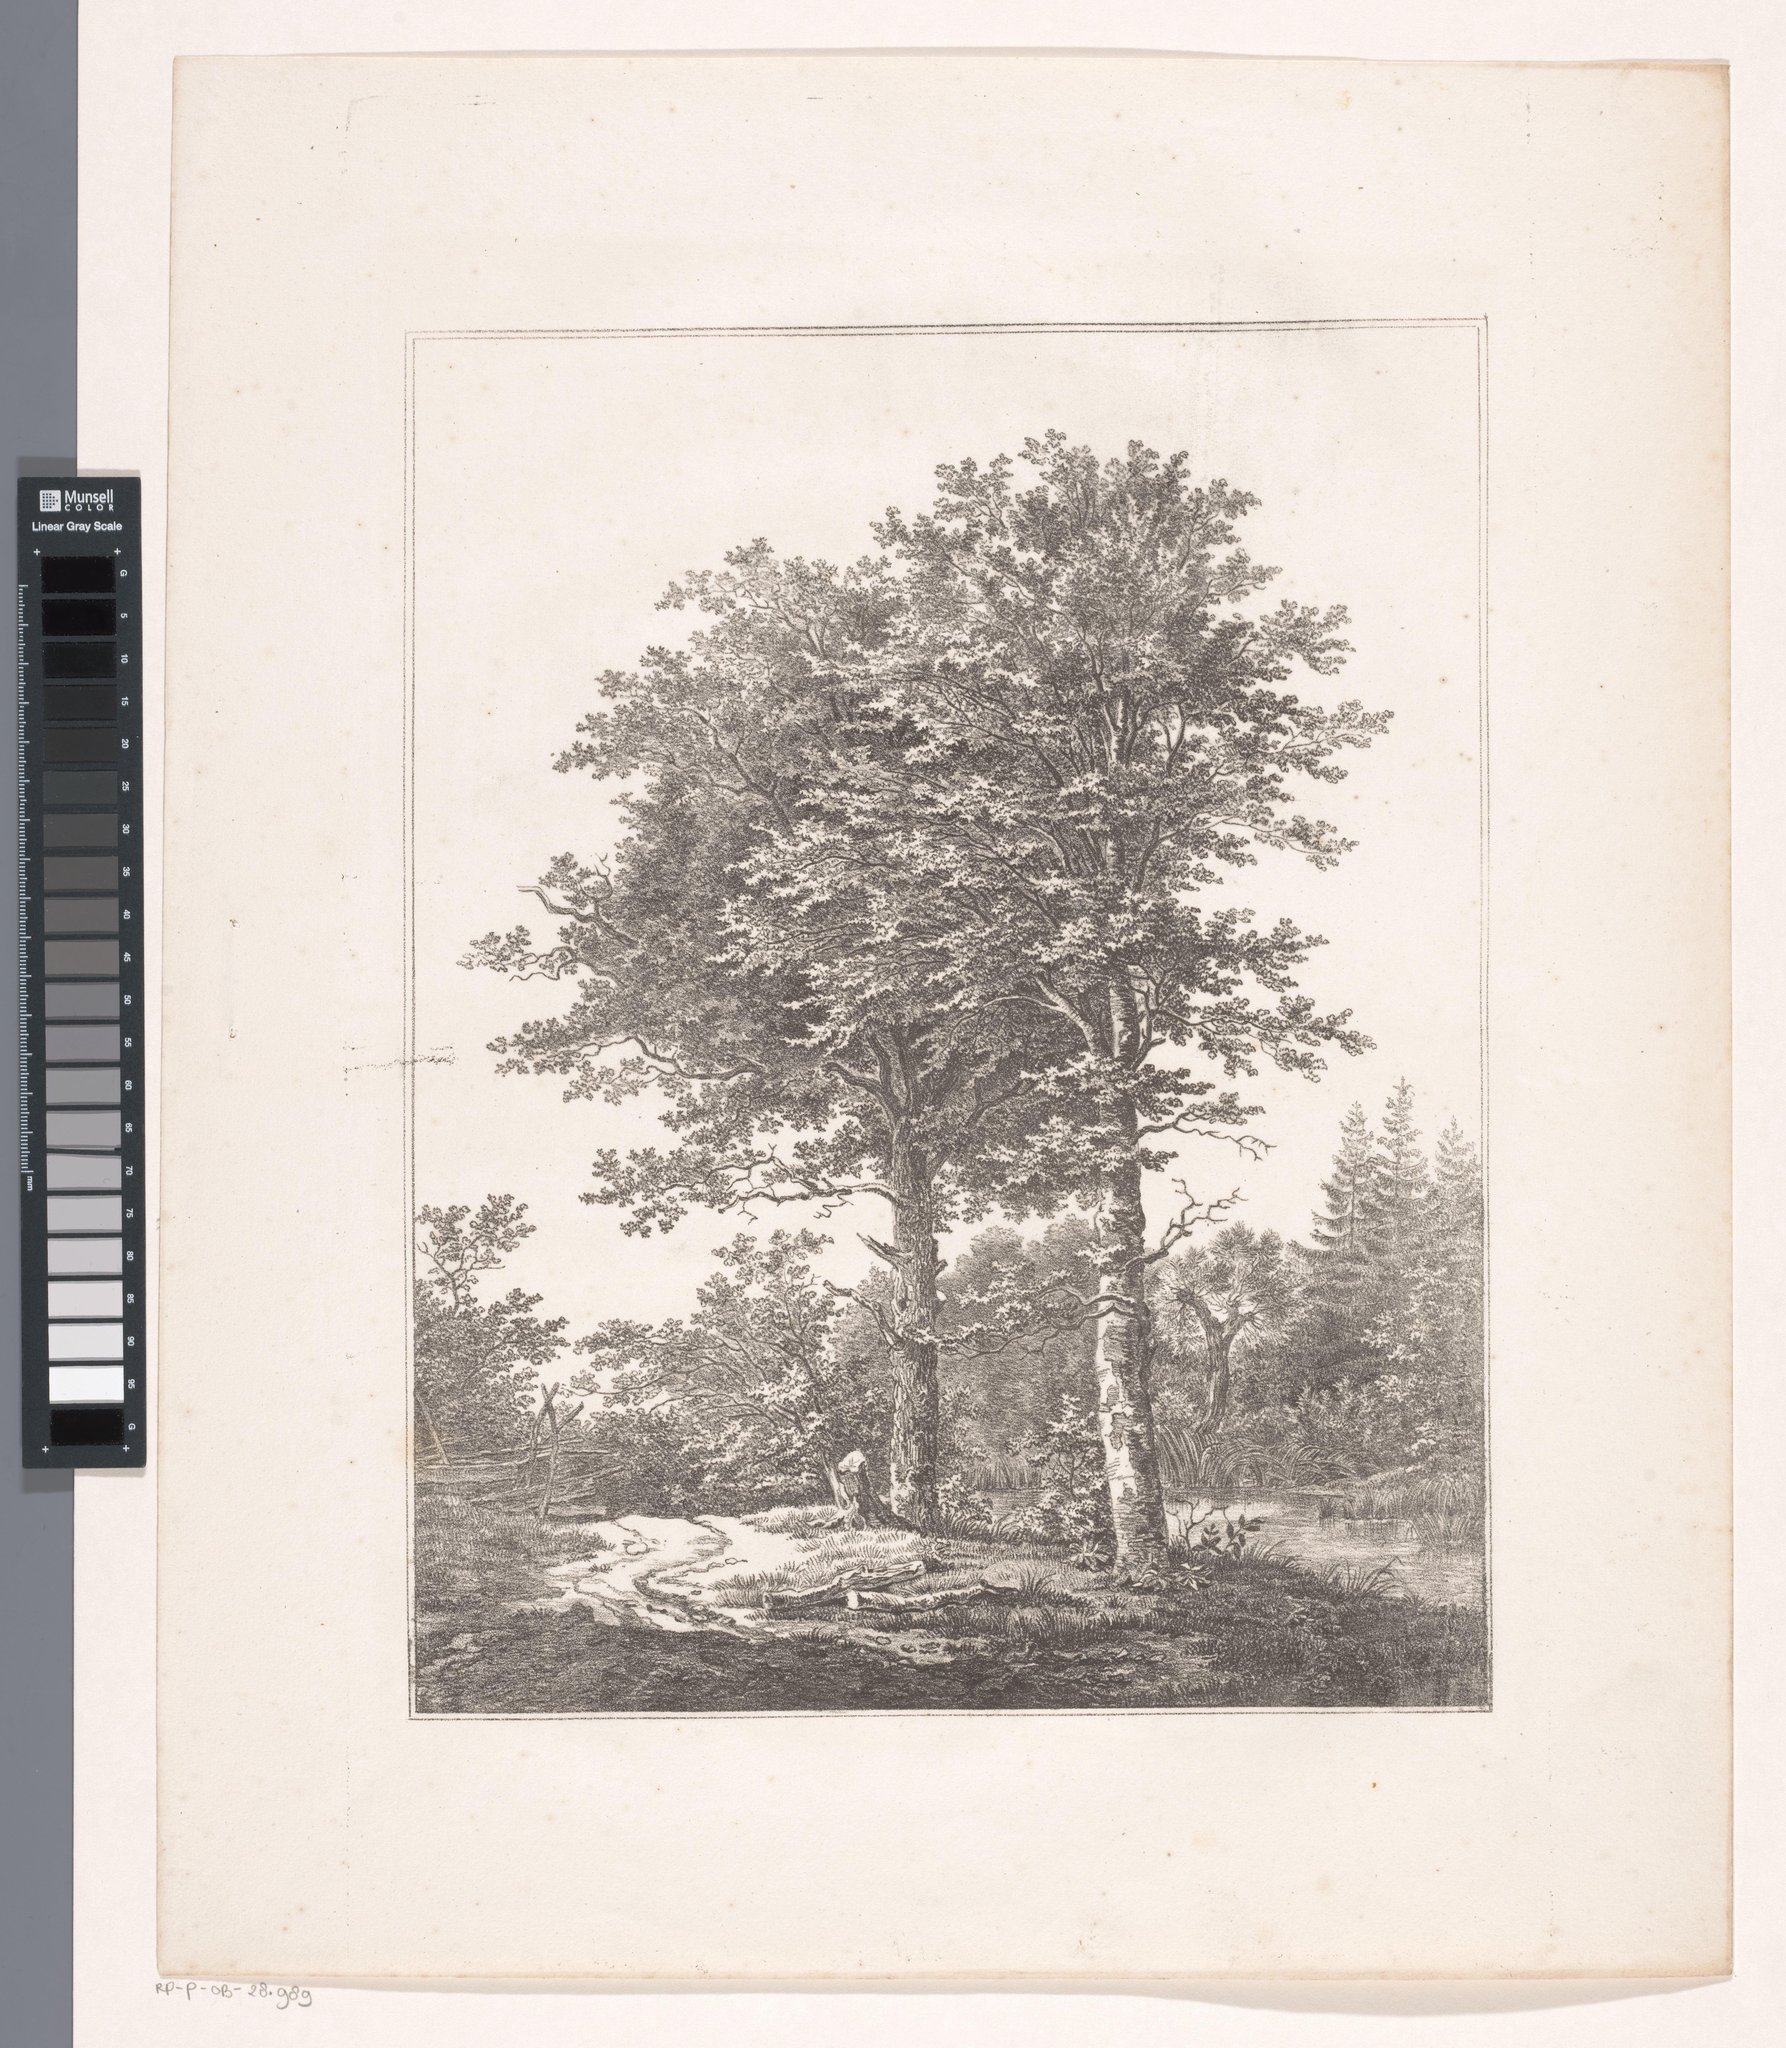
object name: print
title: Boomstudiën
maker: adrianus van der koogh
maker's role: draughtsman, print maker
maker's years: 1796-1831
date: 1826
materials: paper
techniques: lithograph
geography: dordrecht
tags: forest, wood, groups of trees, small canal, ditch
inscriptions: collector's mark: Lugt 2228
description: In 1826 gaf Steuerwald & Comp een serie boomstudies uit van Adrianus van der Koogh, bedoeld voor het tekenonderwijs. Waarschijnlijk maakte deze prent daar deel van uit.